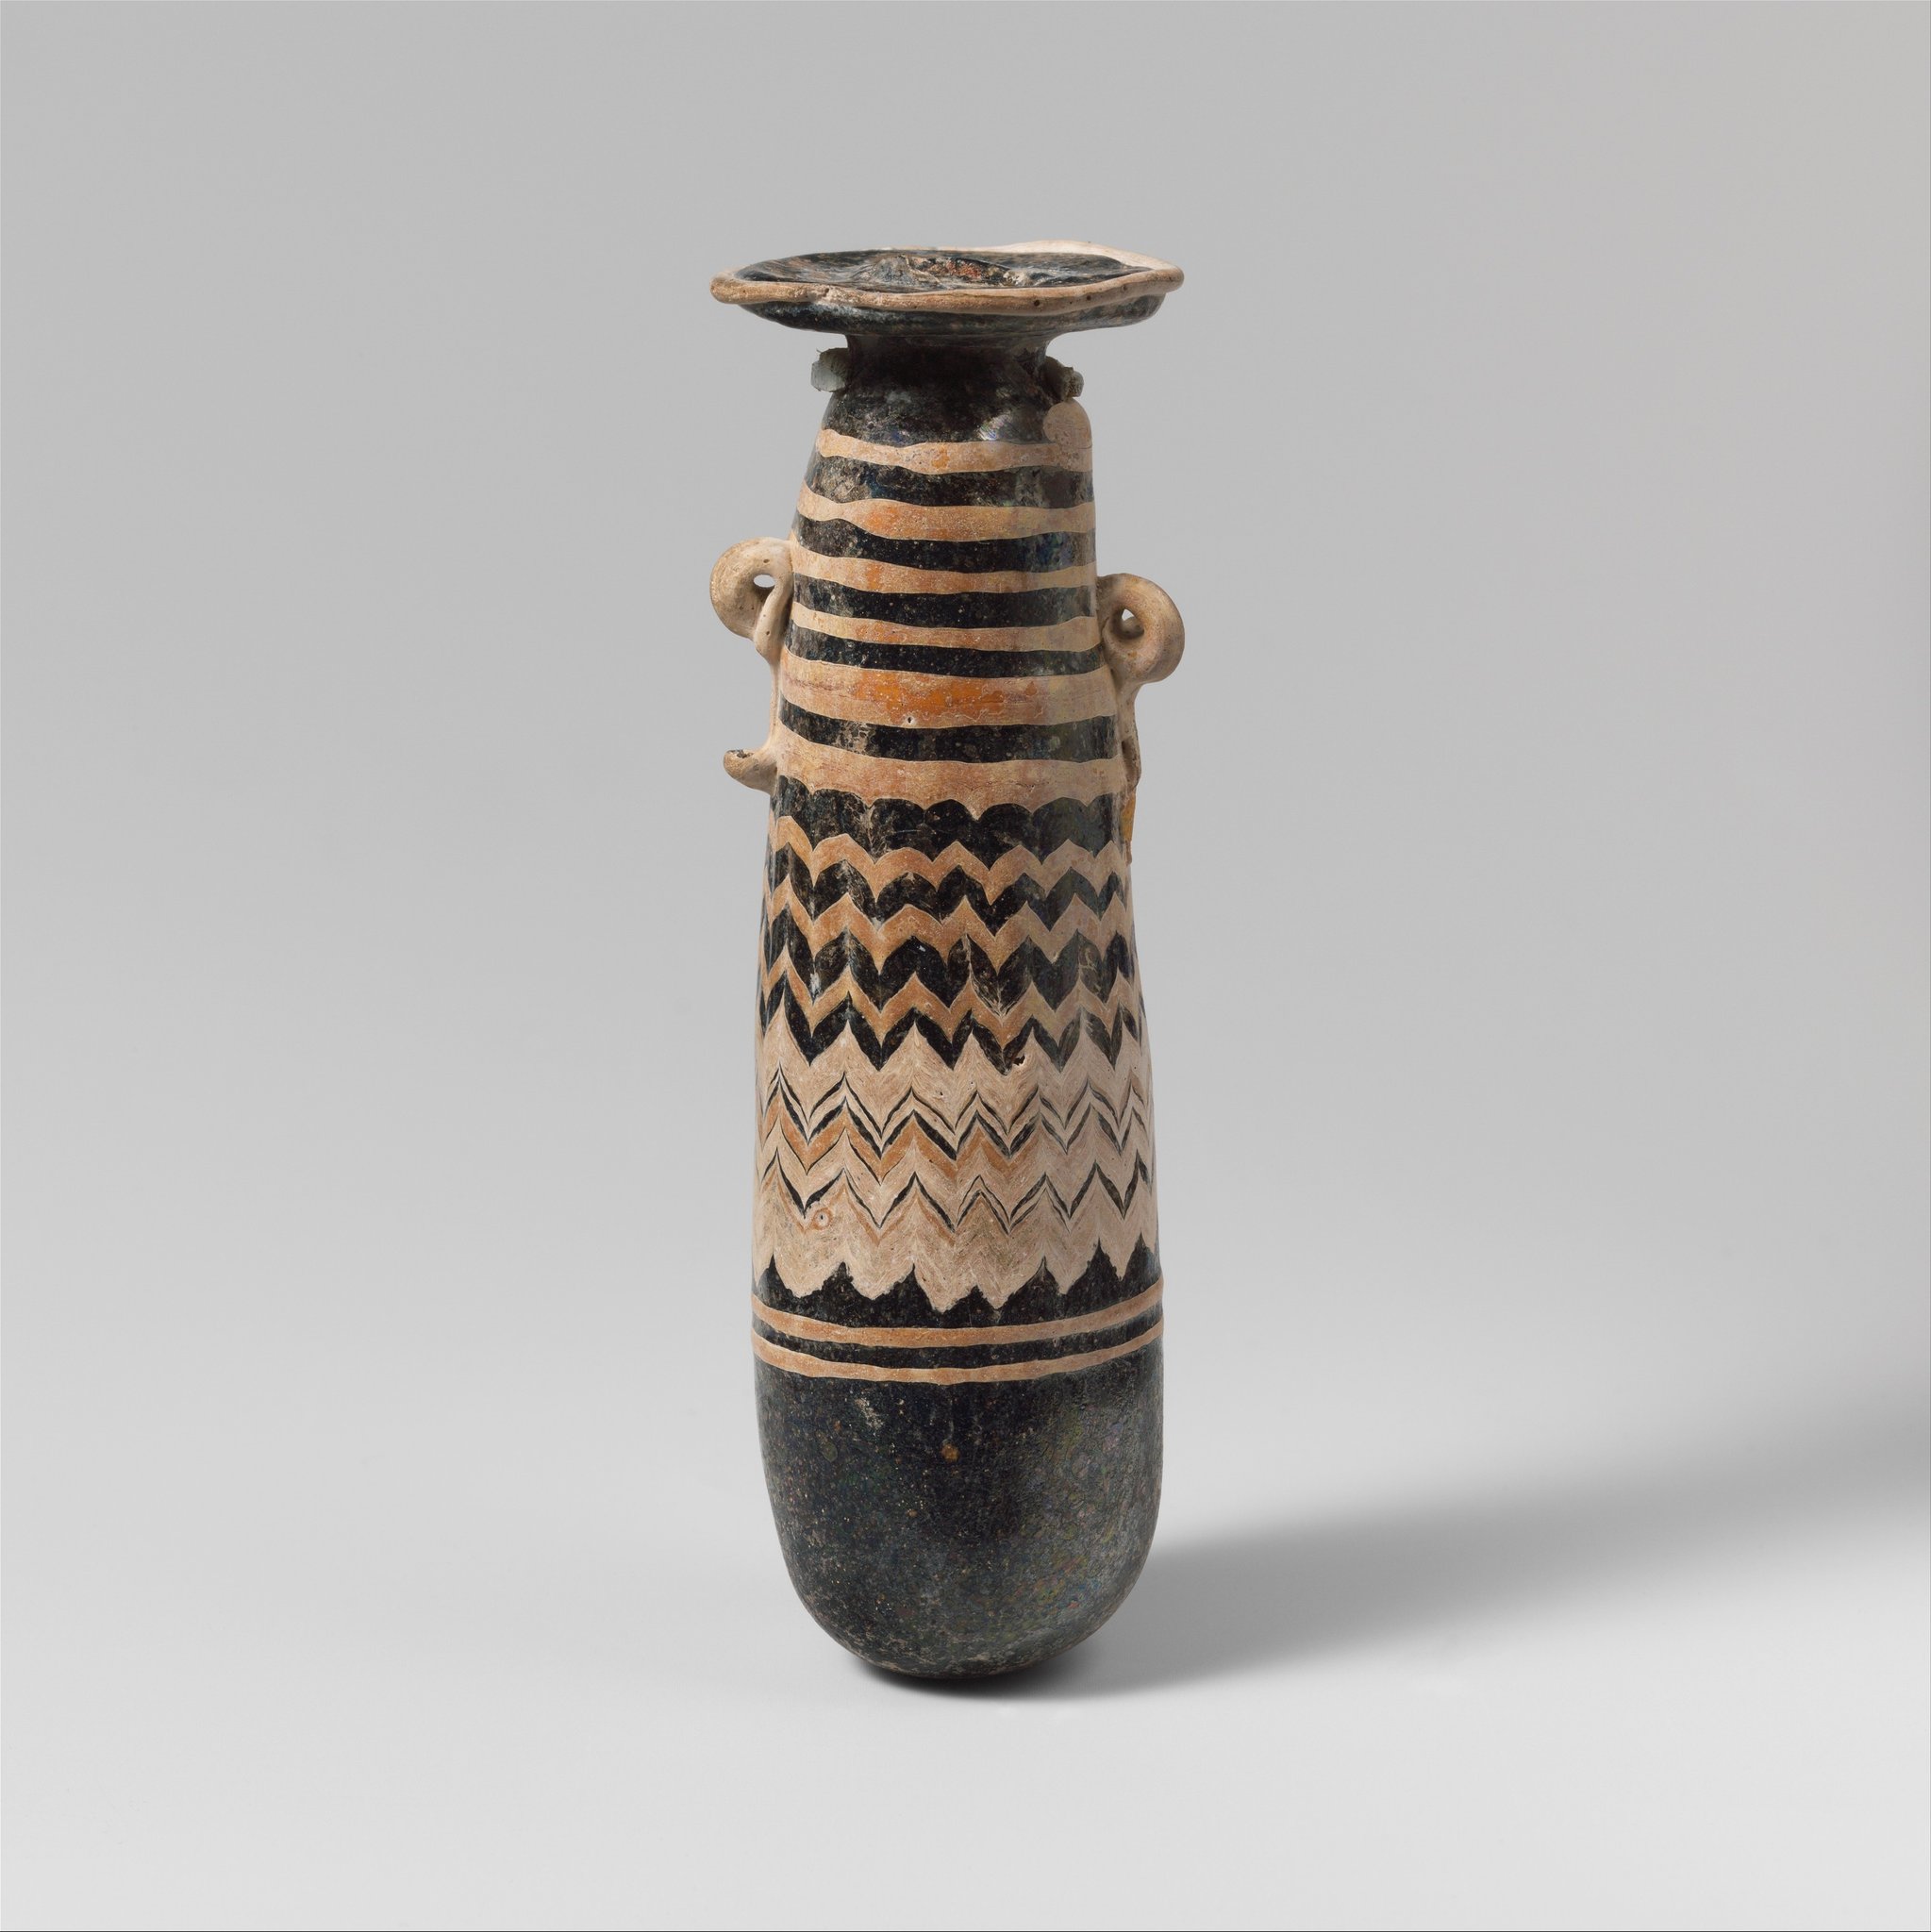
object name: alabastron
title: Glass alabastron (perfume bottle)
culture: greek, eastern mediterranean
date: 534-401 BCE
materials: glass